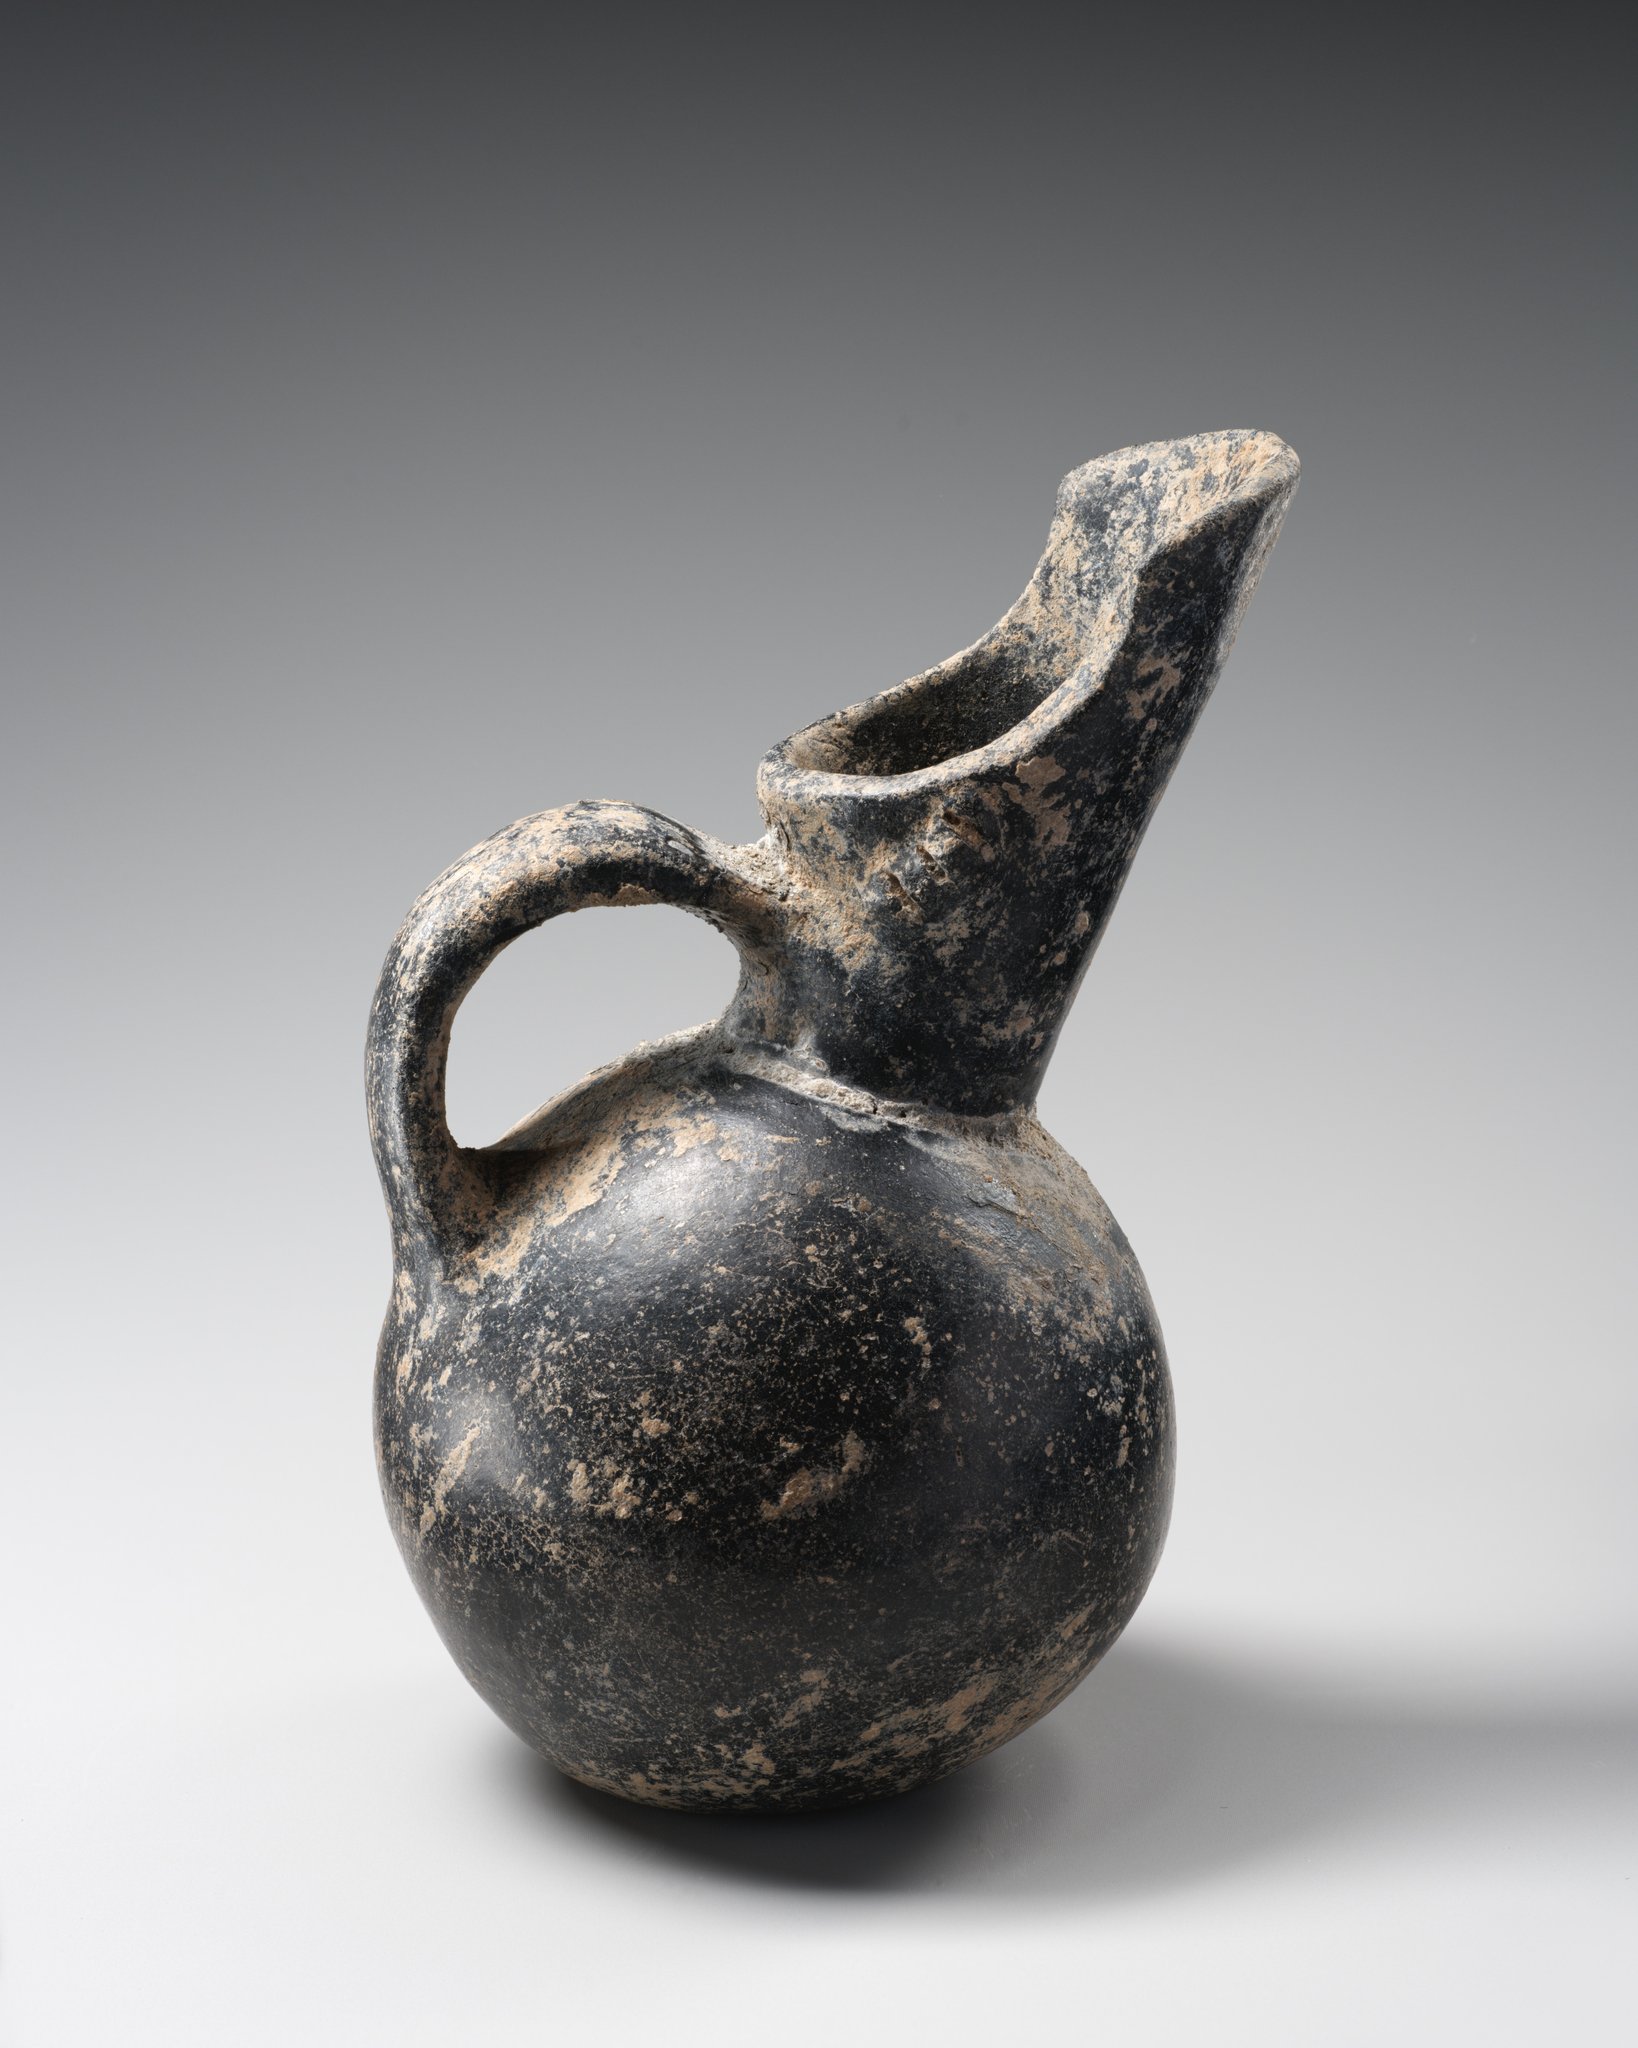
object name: jar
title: Spouted jar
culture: yortan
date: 2700-2400 BCE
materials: ceramic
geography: northwestern anatolia